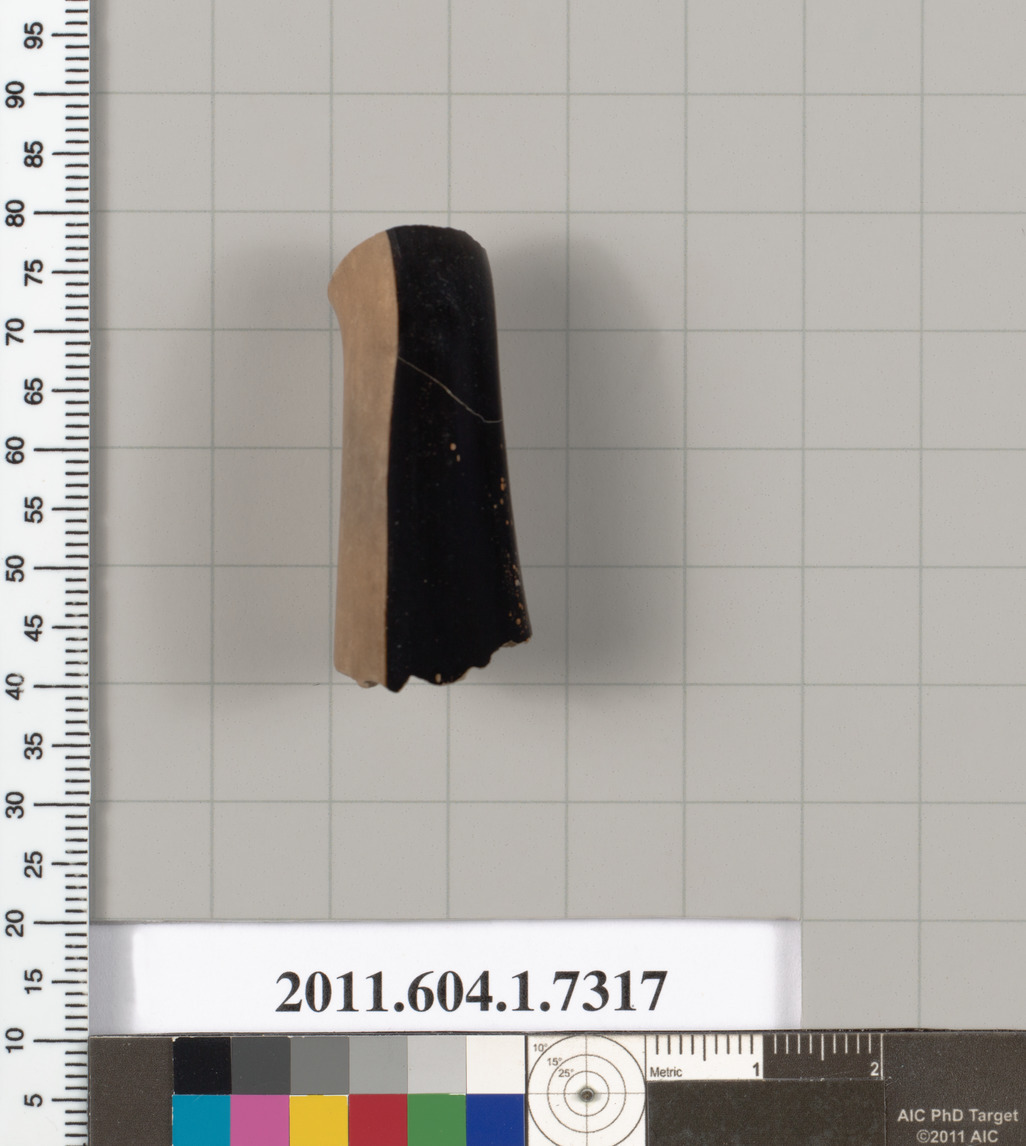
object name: kylix fragment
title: Terracotta fragment of a kylix (drinking cup)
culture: greek, attic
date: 500-480 BCE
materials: terracotta